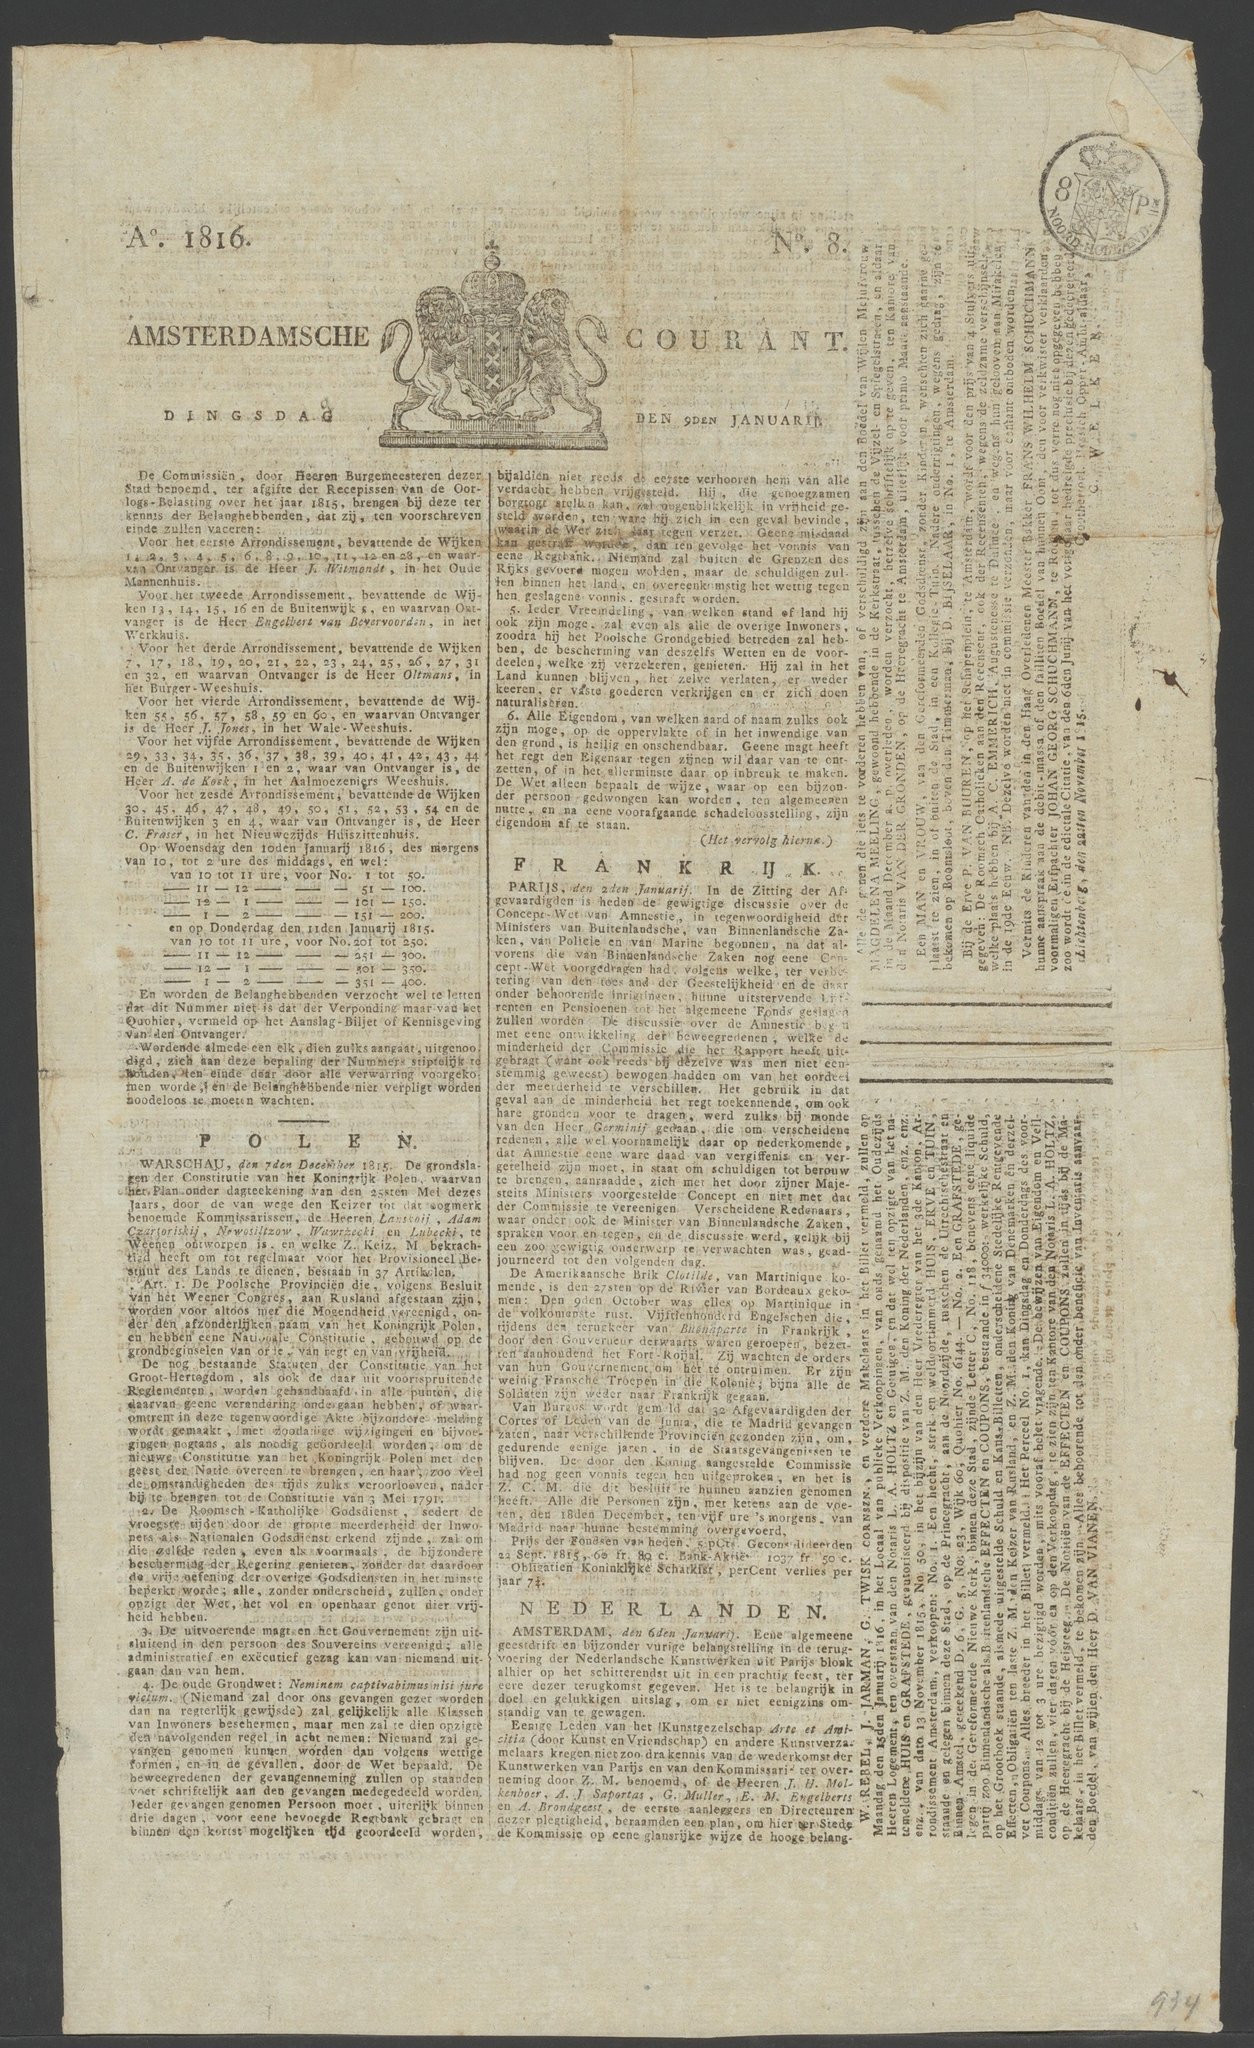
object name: newspaper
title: Amsterdamsche Courant, 9 januari 1816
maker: jacobus van bonga jr.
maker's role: printer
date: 1816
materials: paper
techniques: letterpress printing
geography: amsterdam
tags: newspaper, news-sheet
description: Exemplaar van de krant 'Amsterdamsche Courant' van 9 januari 1816. Dubbelbladig, alle zijden bedrukt. Bovenaan een vignet met het stadswapen. Rechtsboven een stempel betaalde accijnzen. Onderwerpsrubrieken binnen de Atlas Zeden en Gewoonten: Regeering, Officieele Nieuwsbladen.